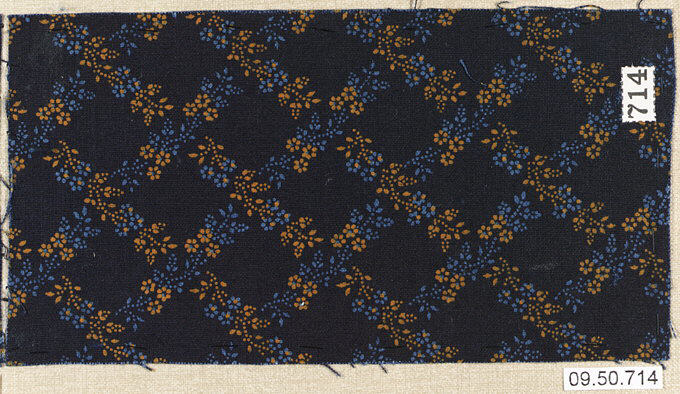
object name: piece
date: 1801-1900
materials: cotton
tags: flowers